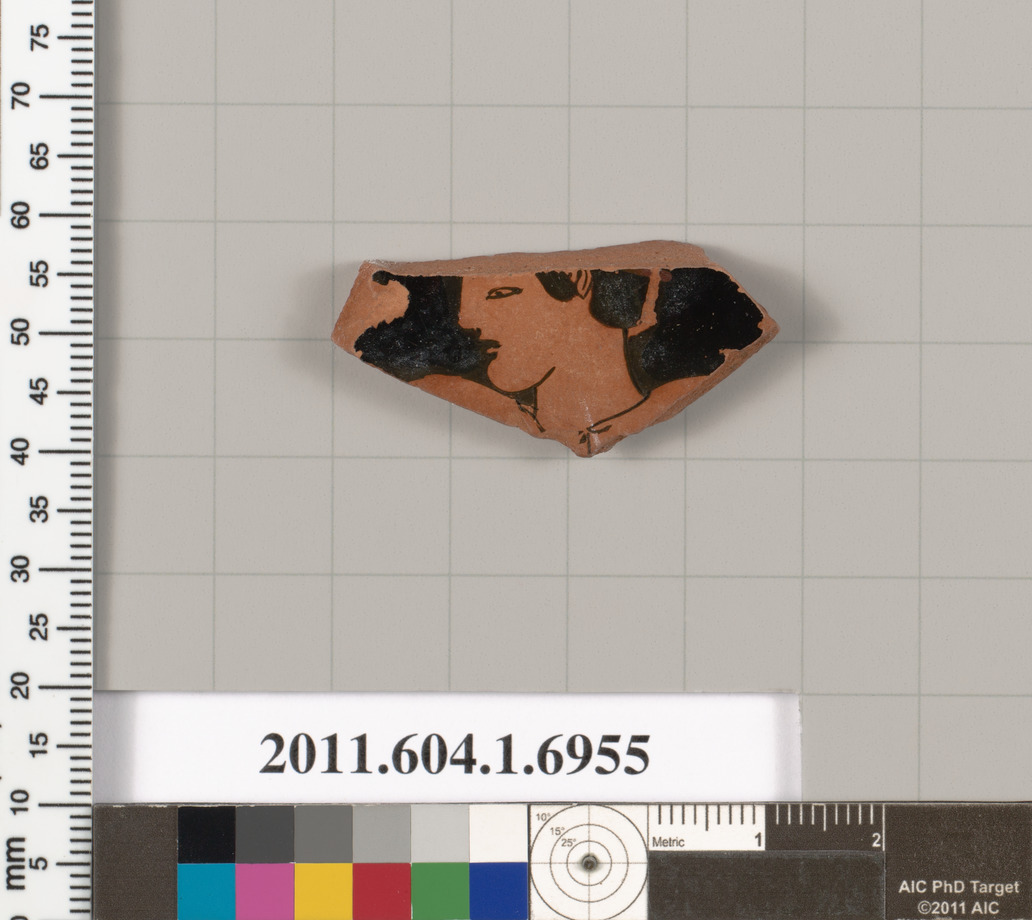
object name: kylix fragment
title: Terracotta fragment of a kylix (drinking cup)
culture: greek, attic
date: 490-470 BCE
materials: terracotta